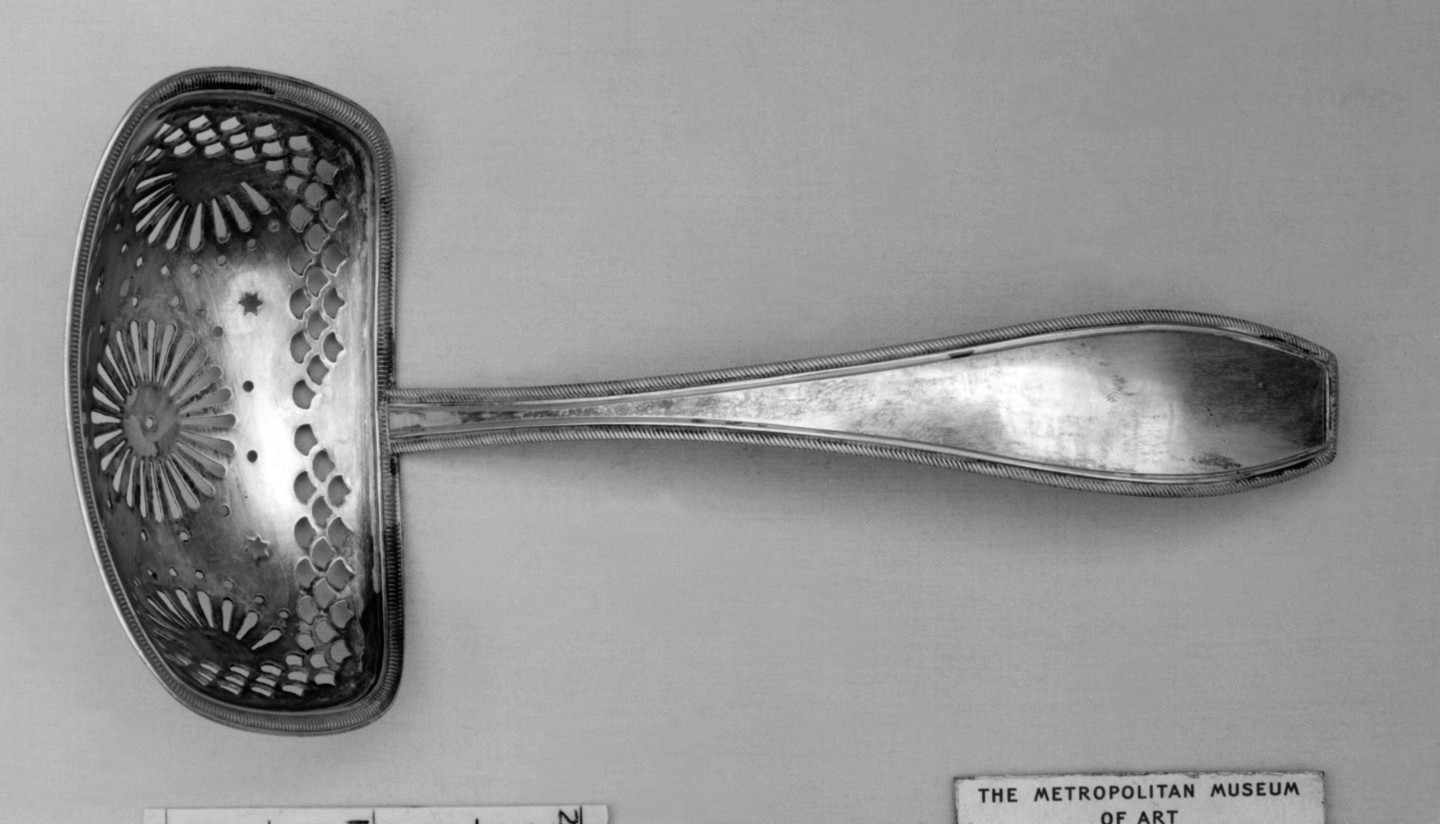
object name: sugar sifter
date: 1801-1833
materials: silver